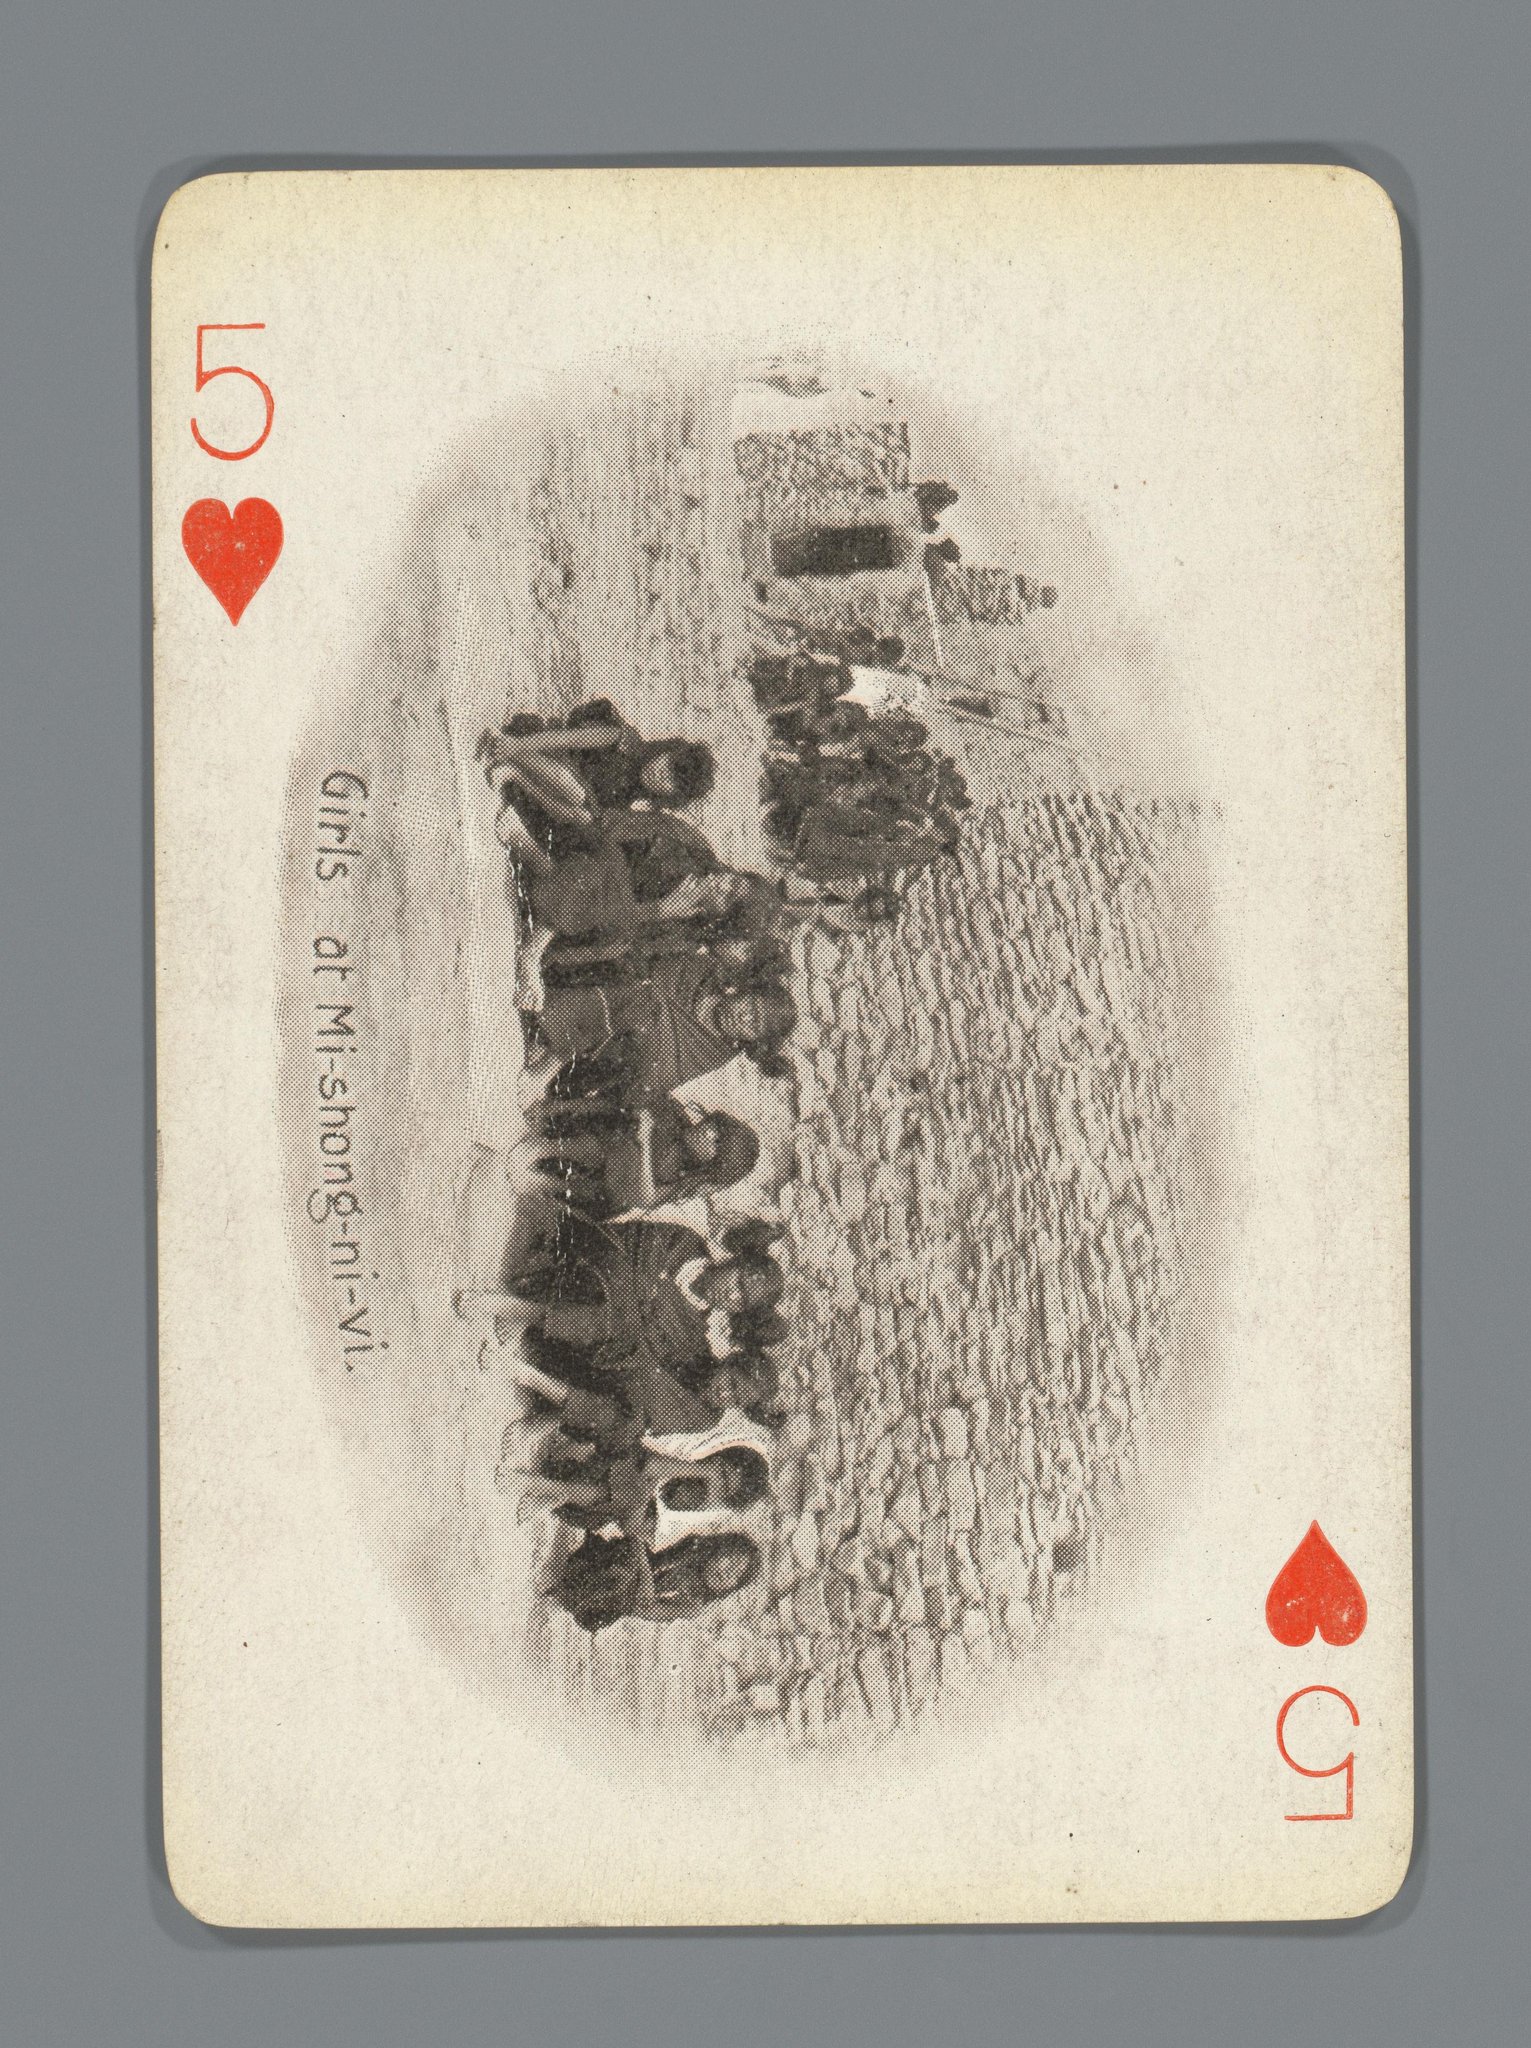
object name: playing card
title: Girls at Mi-shong-ni-vi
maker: adam clark vroman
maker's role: fotograaf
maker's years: 1856-1916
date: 1900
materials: paper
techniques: autotype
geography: los angeles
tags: arizona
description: Speelkaart uit doosje met 53 speelkaarten met afbeeldingen in autotypie van Native Americans. De inhoud bevat een complete set speelkaarten inclusief joker.